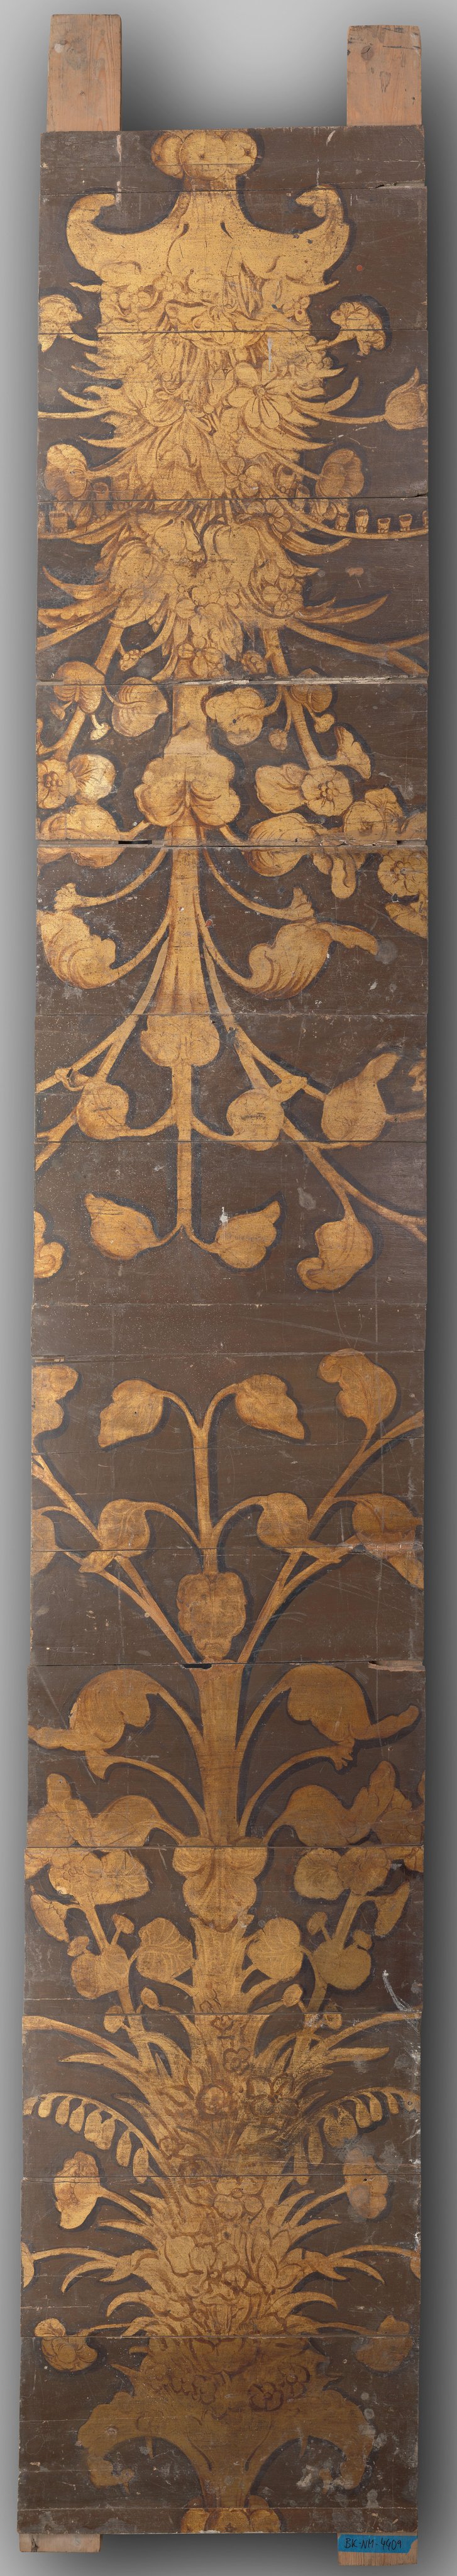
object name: architectural element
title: Tongewelf, samengesteld uit eiken planken, beschilderd met grotesken en acanthusranken, afgewende vrouwenfiguren met onderlijven die eindigen in klauwen en voluten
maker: Anonymous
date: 1600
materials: wood, paint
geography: northern netherlands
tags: the hague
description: Gewelf bestaande uit ongeveer 150 panelen van verschillende grootte. Onderdelen 127 t/m 130, onderdelen 48 t/m 52, onderdelen 112 t/m 116, onderdelen 68 t/m 74, onderdelen 160 t/m 164, onderdelen 107 t/m 111, onderdelen 96 t/m 100 en onderdelen 61 t/m 67.